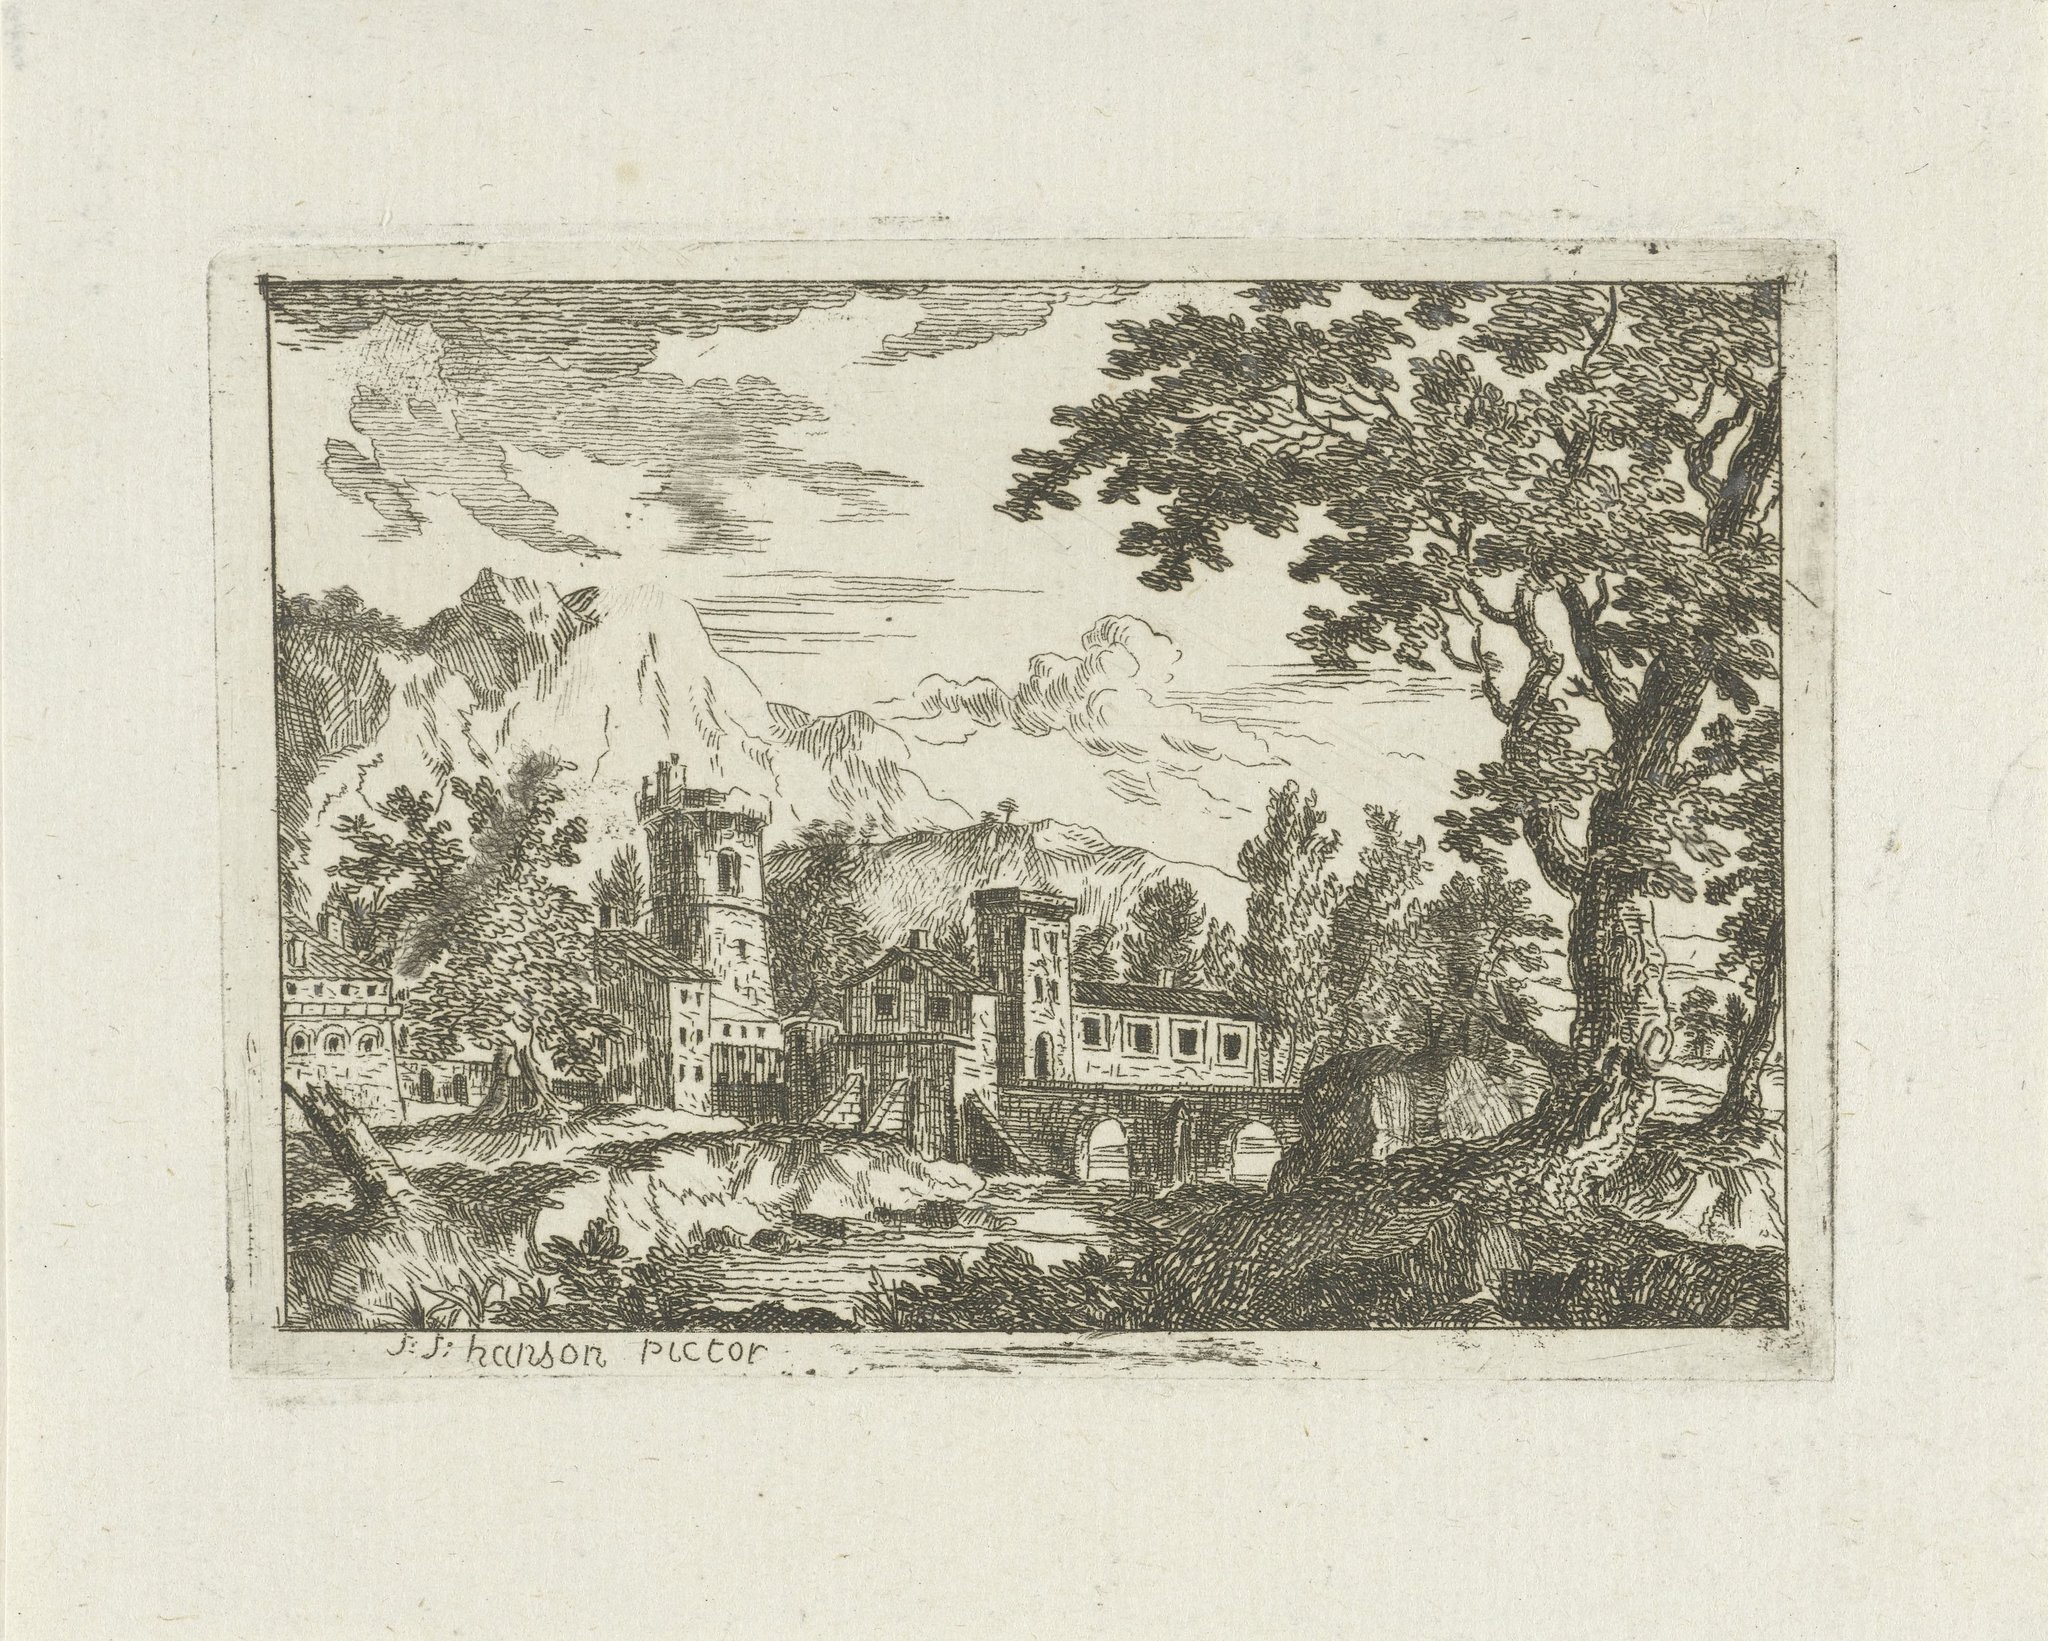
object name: print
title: Stenen gebouwen aan een rivier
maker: jean joseph hanson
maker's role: painter, print maker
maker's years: 1731-1799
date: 1741-1799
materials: paper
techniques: etching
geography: southern netherlands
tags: prospect of village, silhouette of village, landscape with bridge, viaduct or aqueduct, landscape with tower or castle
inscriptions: collector's mark: Lugt 2228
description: Stenen gebouwen en torens aan een rivier waarover een stenen brug met twee bogen.